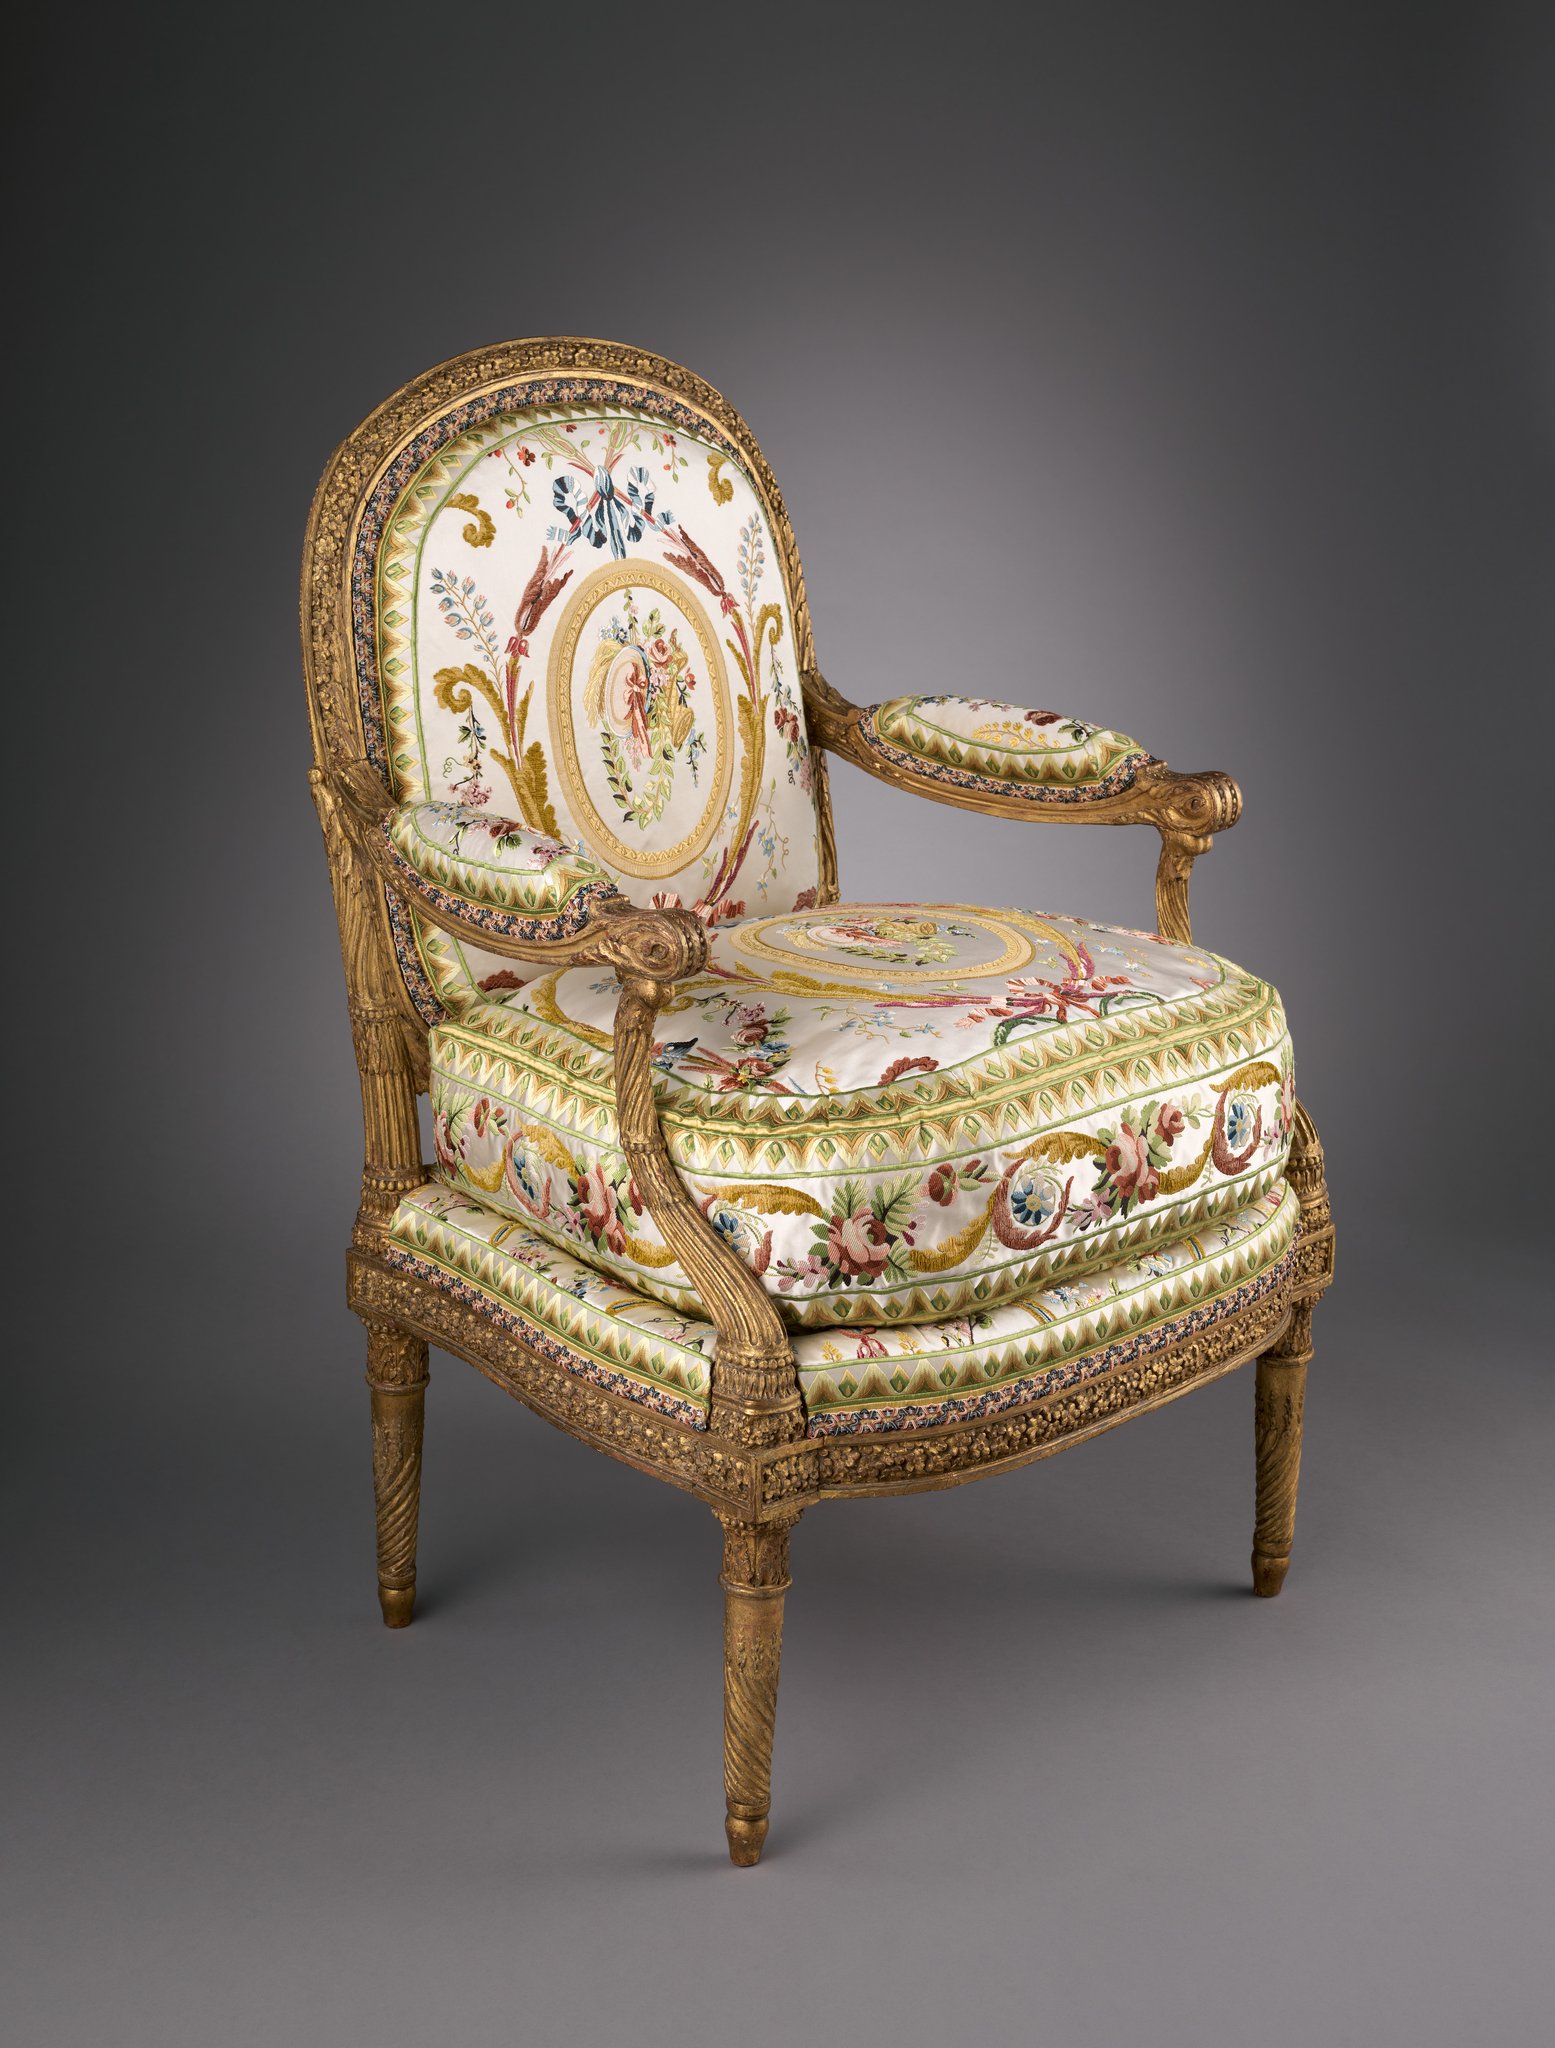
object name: armchair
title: Armchair (fauteuil à la reine)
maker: jacques gondouin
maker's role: designer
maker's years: 1737-1818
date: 1779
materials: wood, silk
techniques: carving, gilding, lampas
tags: flowers